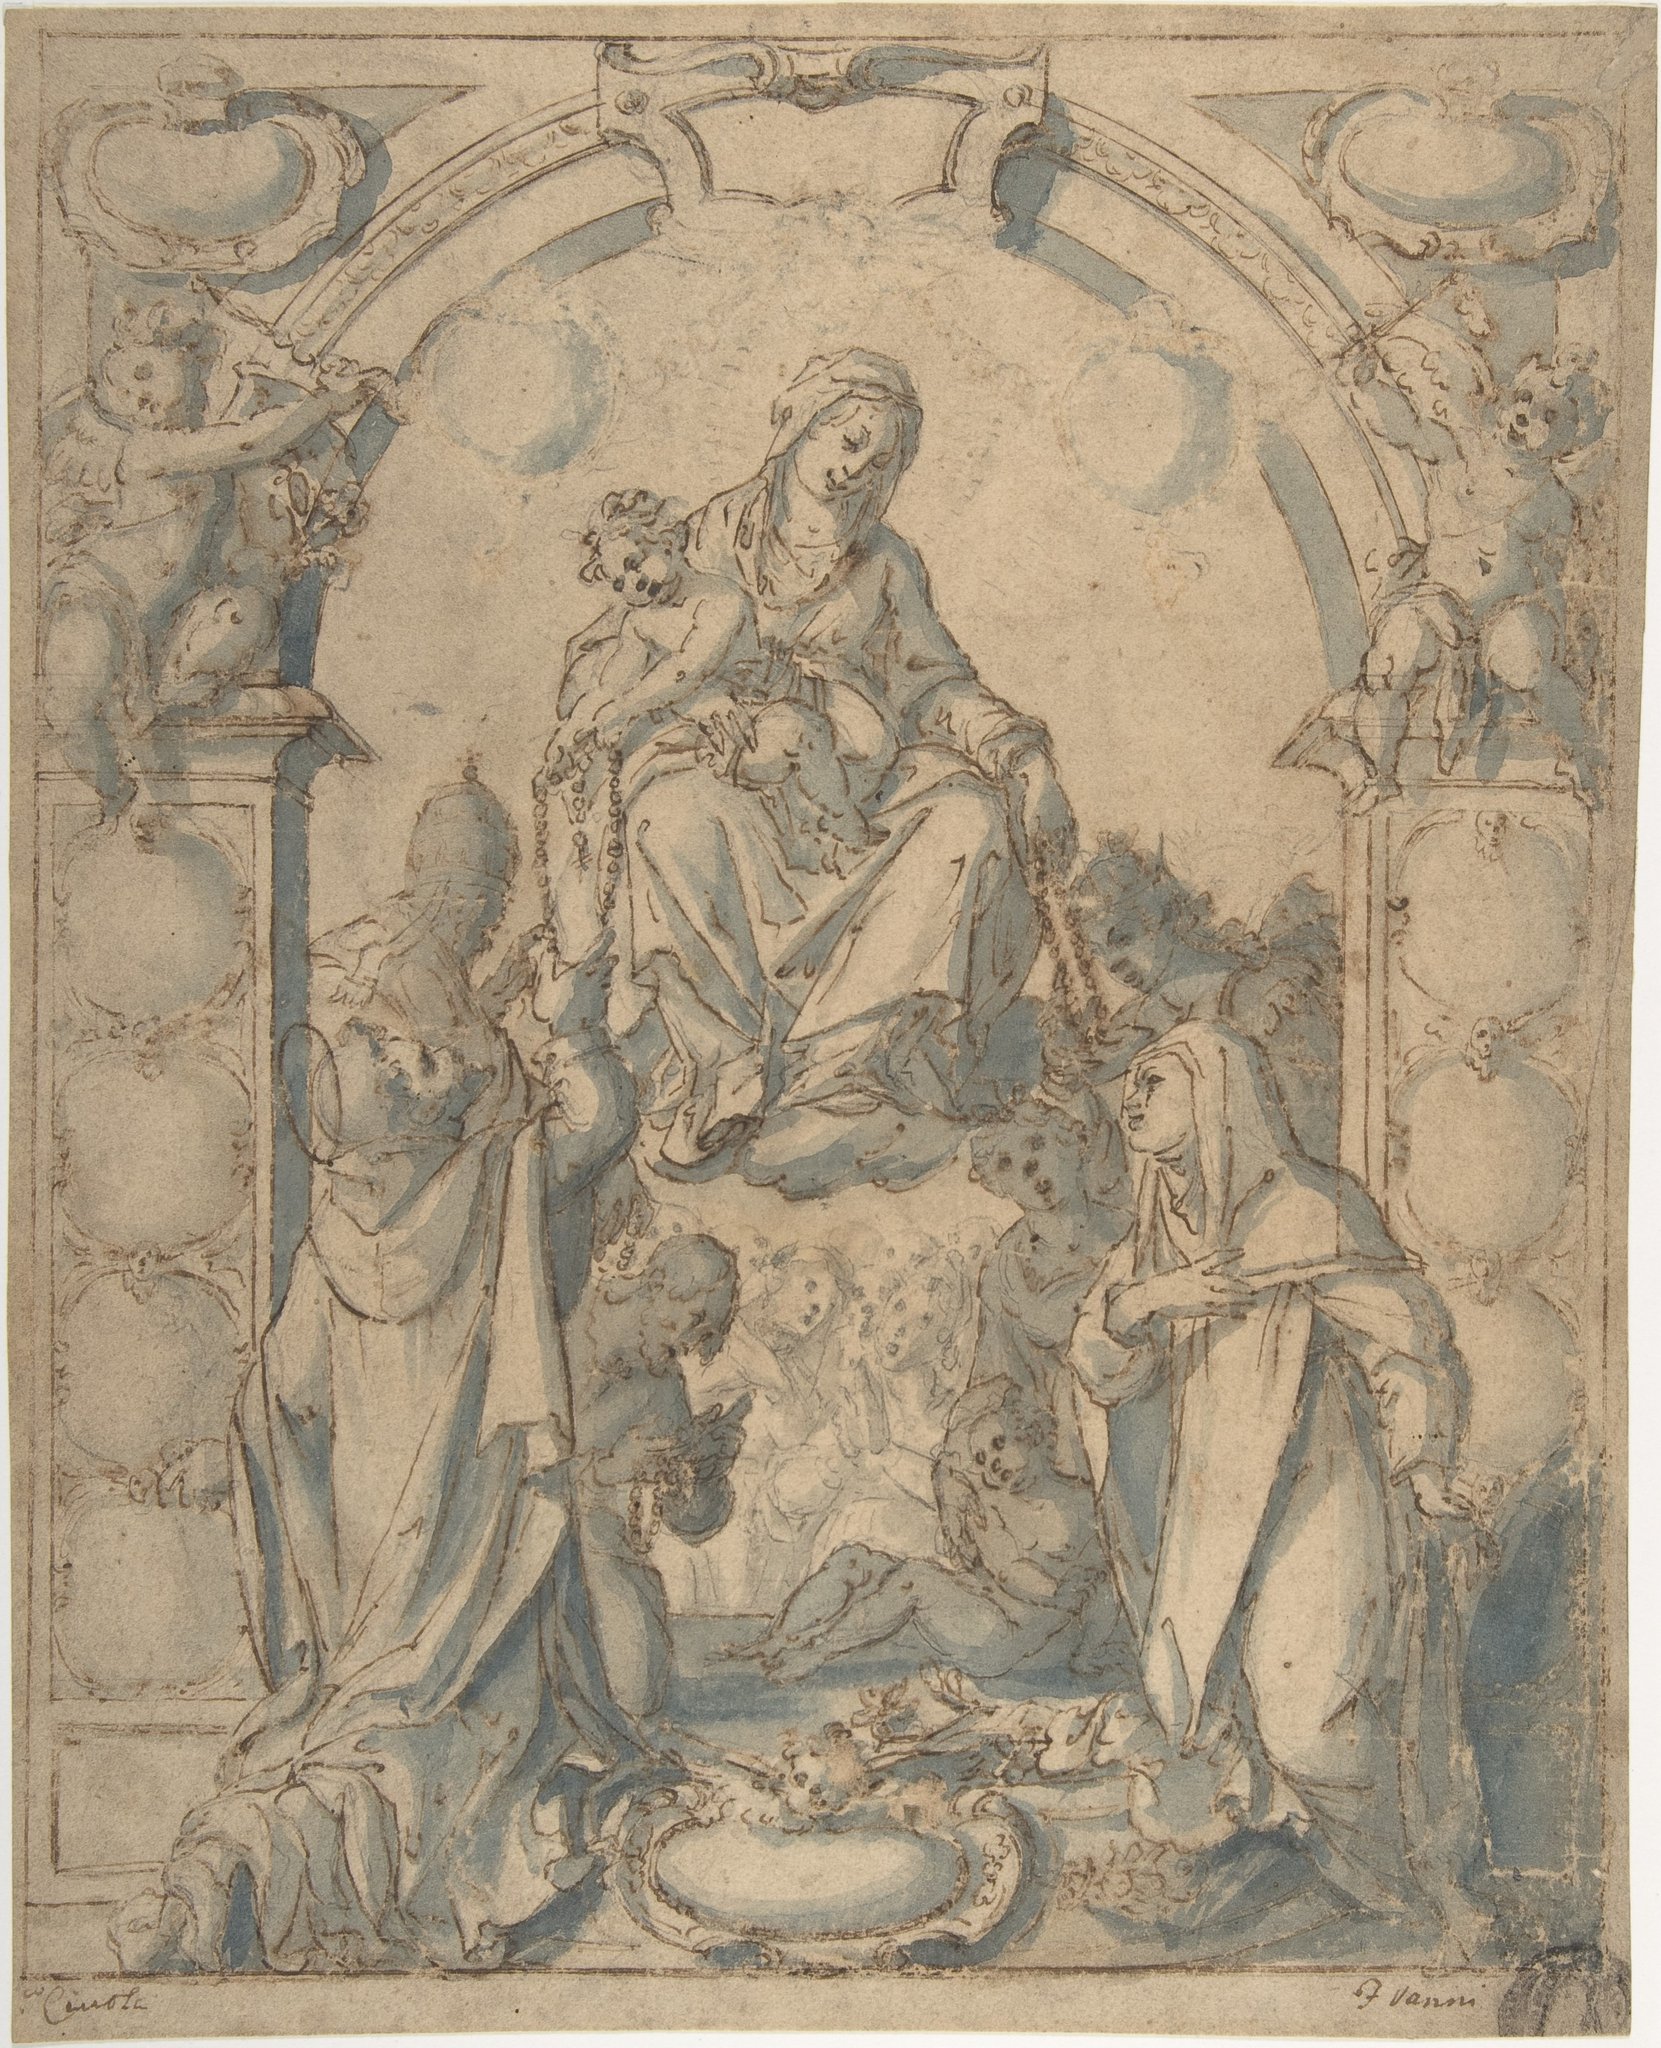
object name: drawing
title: Madonna and Child Adored by Two Saints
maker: anonymous, italian, 16th century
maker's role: artist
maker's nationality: italian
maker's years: 1550-1600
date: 1501-1600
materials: chalk, ink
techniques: brush, pen, wash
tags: madonna and child,saints